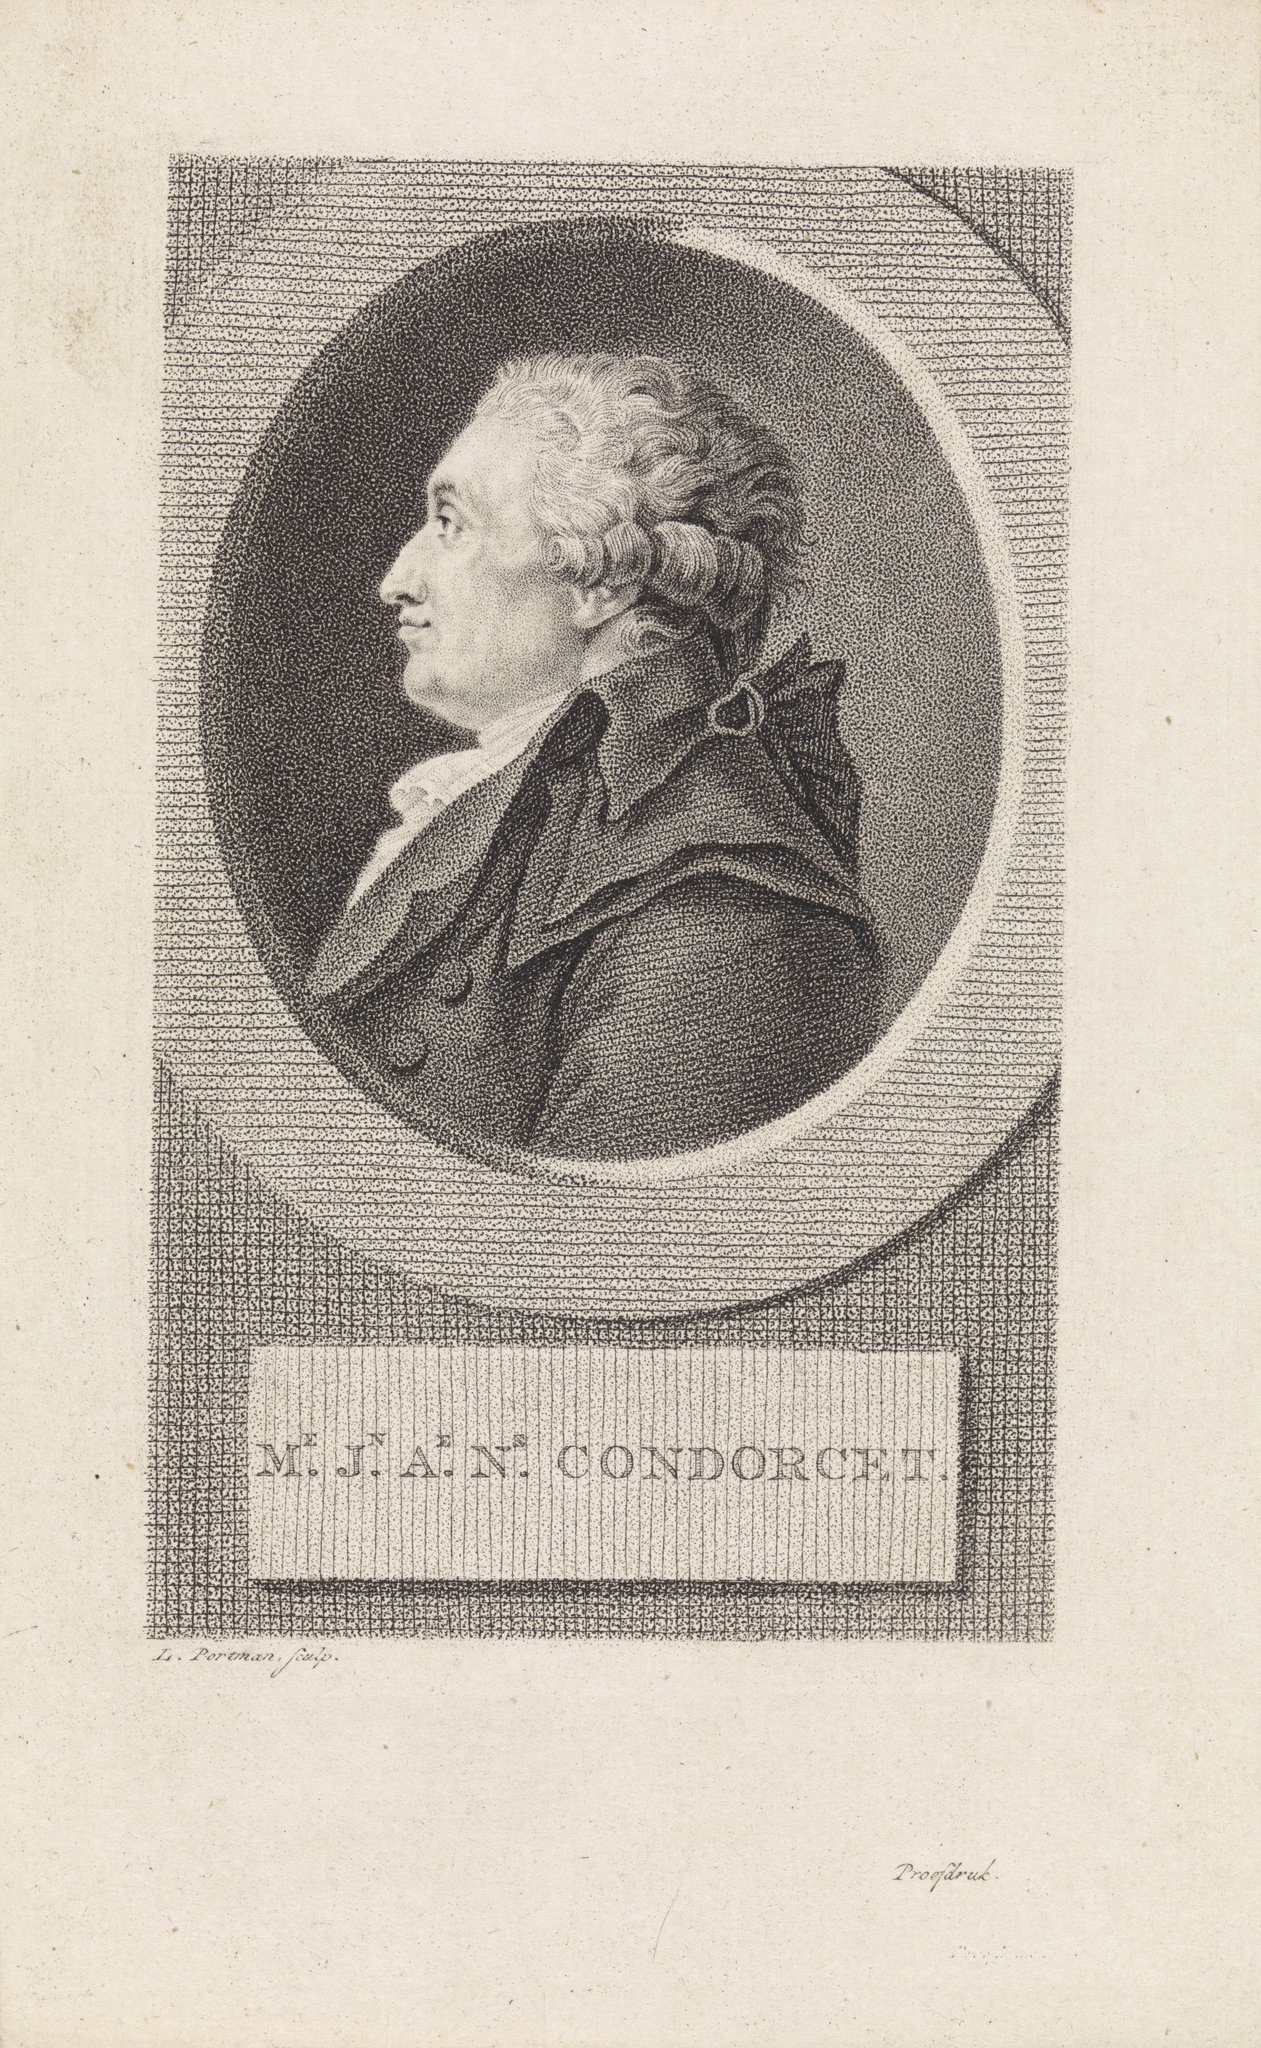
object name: print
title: Portret van de Franse filosoof Marie Jean Antoine Nicolas de Caritat, markies de Condorcet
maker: ludwig gottlieb portman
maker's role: print maker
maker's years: 1772-1828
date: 1804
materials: paper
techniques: etching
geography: amsterdam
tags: ribemont, bourg-la-reine, filosoof, wiskundige, nicolas de caritat (markies de condorcet)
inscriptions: collector's mark: Lugt 2228